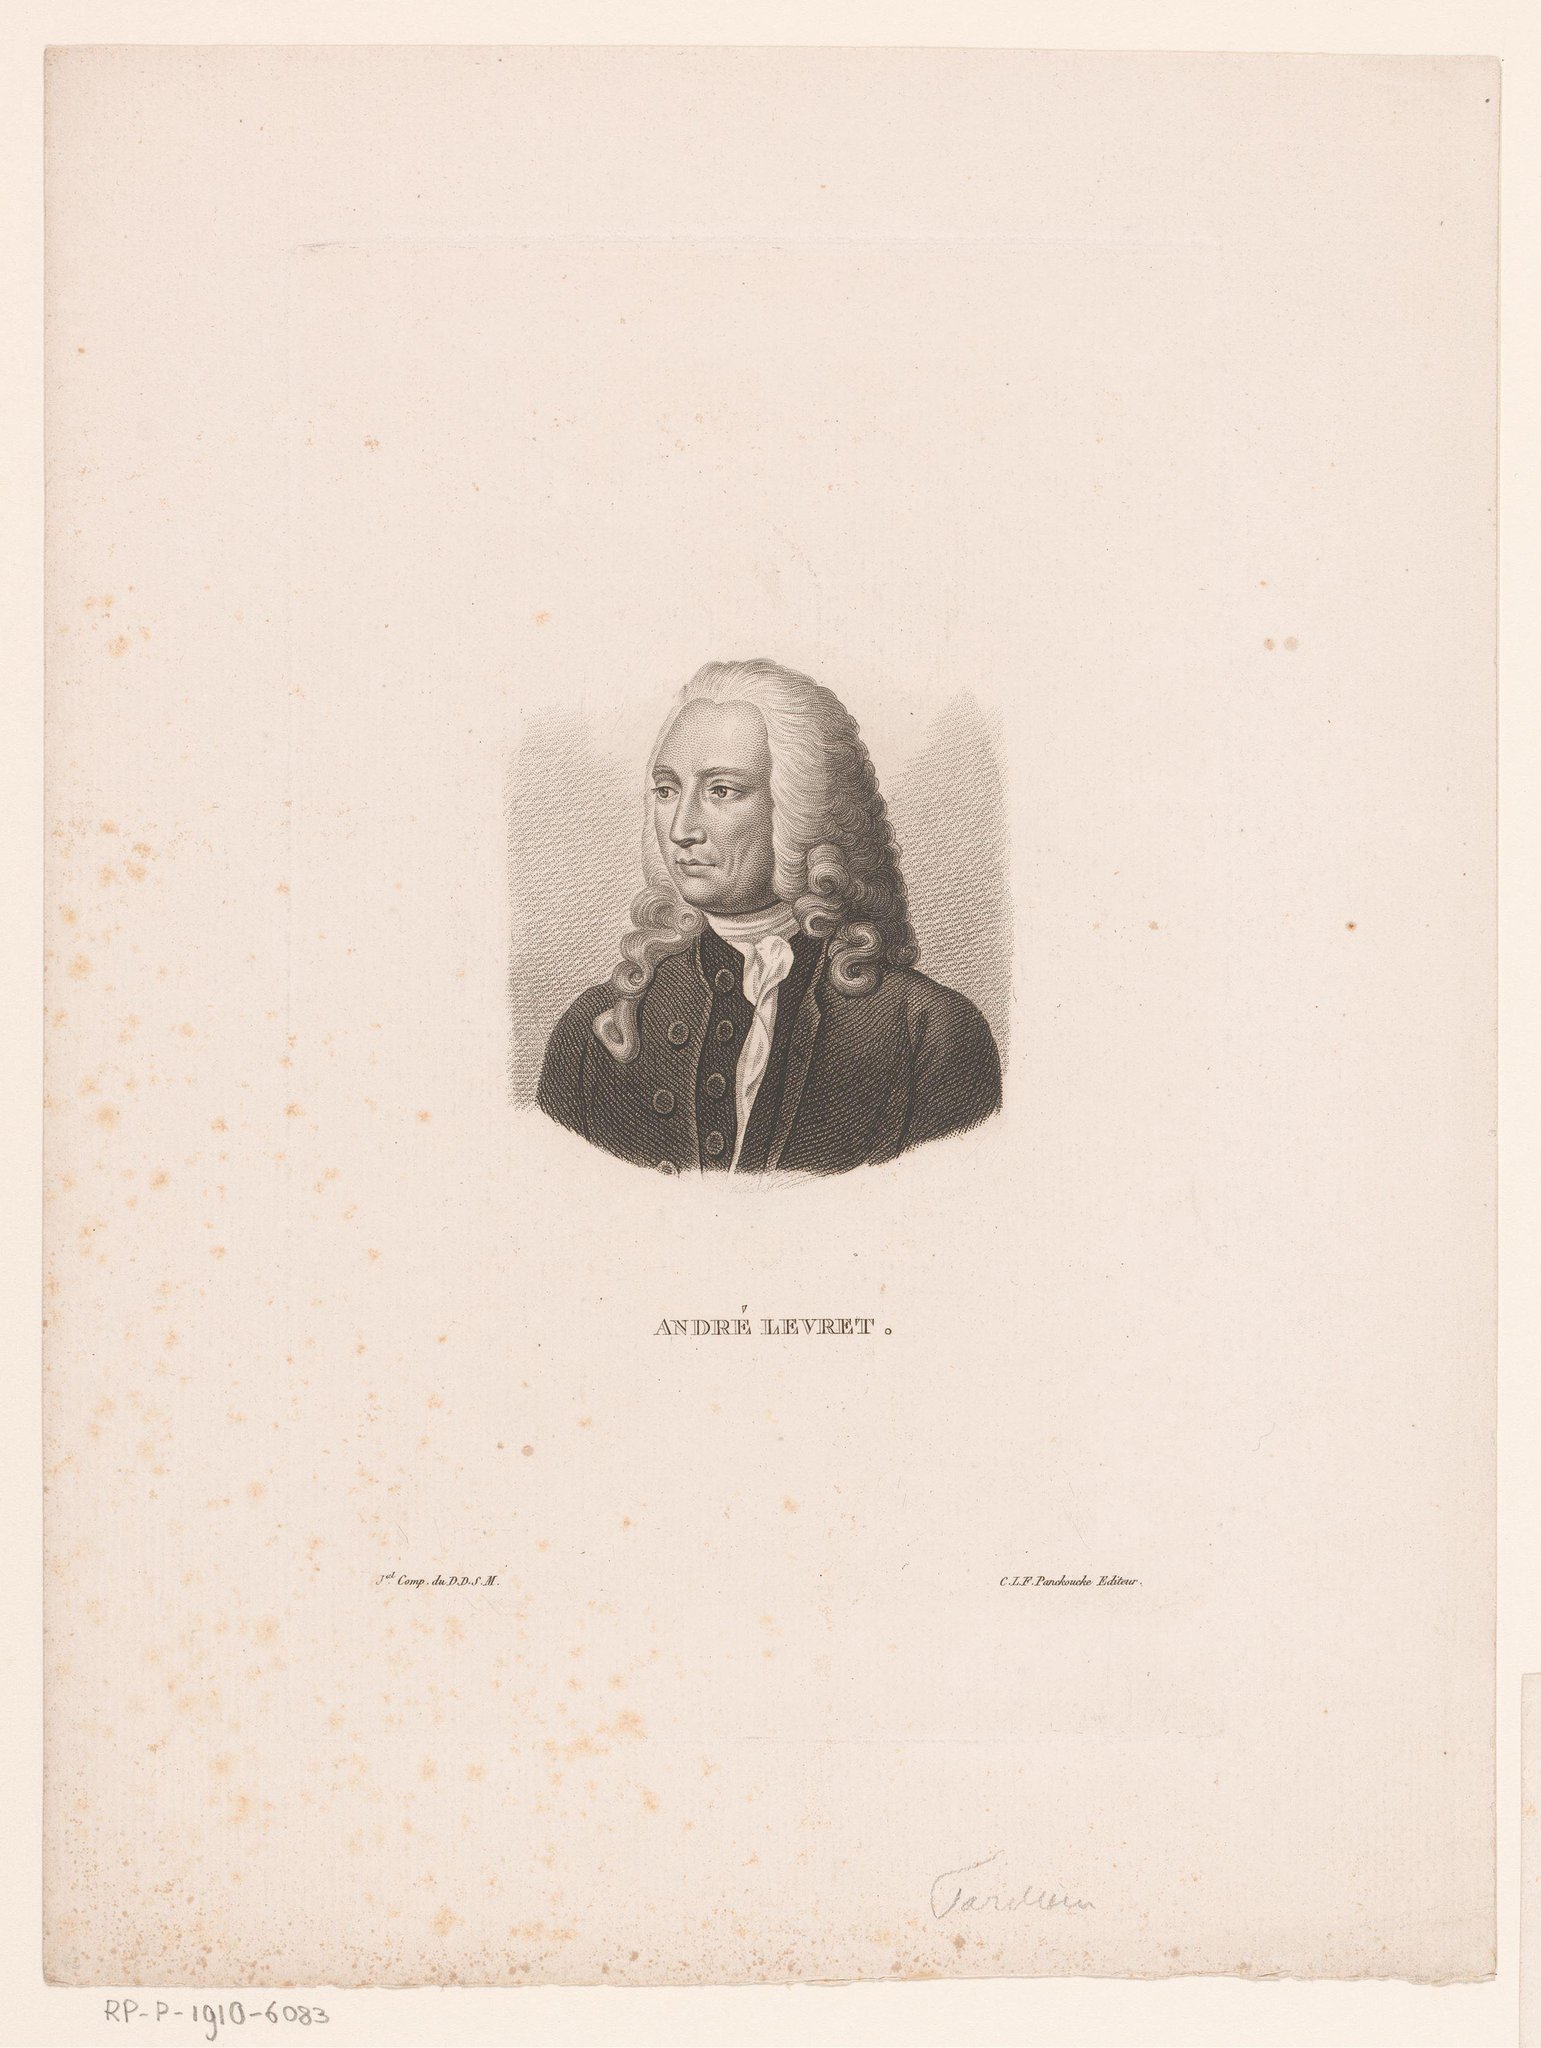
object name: print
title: Portret van André Levret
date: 1818-1832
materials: paper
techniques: engraving, roulette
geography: paris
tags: paris, historical persons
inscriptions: collector's mark: Lugt 2228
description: Prent uit: Journal complémentaire du Dictionnaire des sciences médicales. Parijs: Panckoucke, Charles Louis Fleury, 1818-1832.